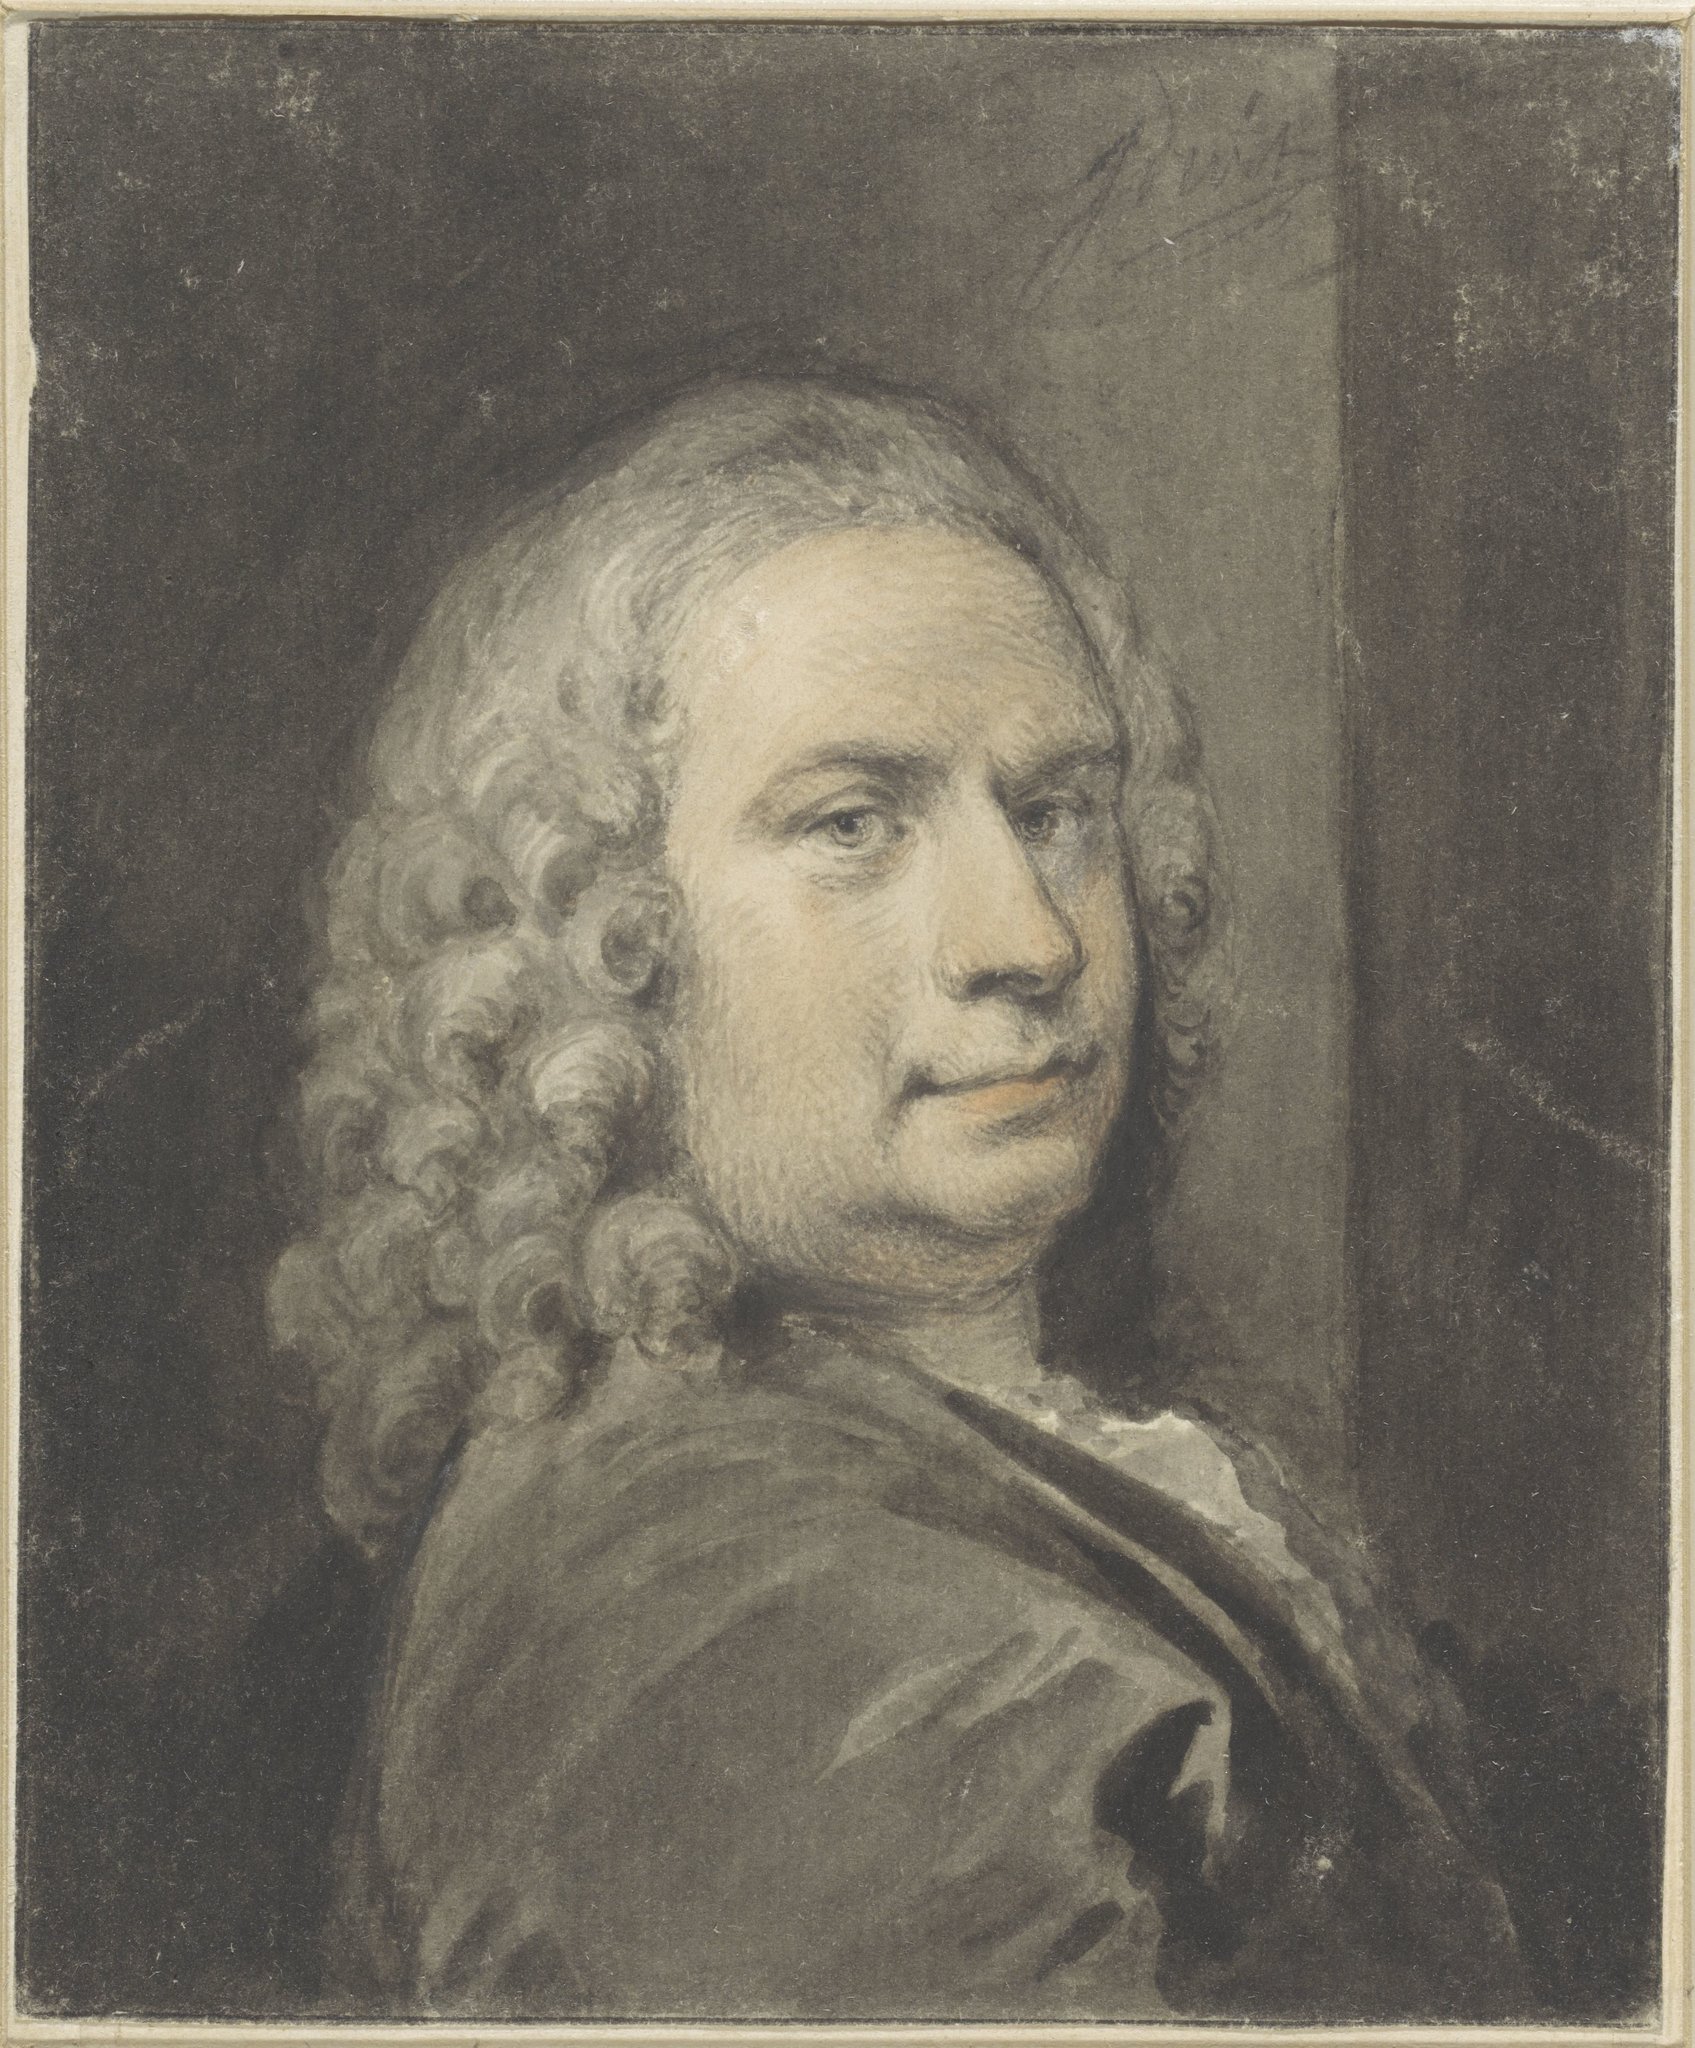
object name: drawing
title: Zelfportret van Jacob de Wit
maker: jacob de wit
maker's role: draughtsman, painter, print maker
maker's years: 1695-1754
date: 1705-1754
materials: chalk, paper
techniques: brush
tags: amsterdam, painter, print maker, draughtsman, jacob de wit, historical persons, portrait, self-portrait of artist, portrait, self-portrait of graphic artist, portrait, self-portrait of draughtsman